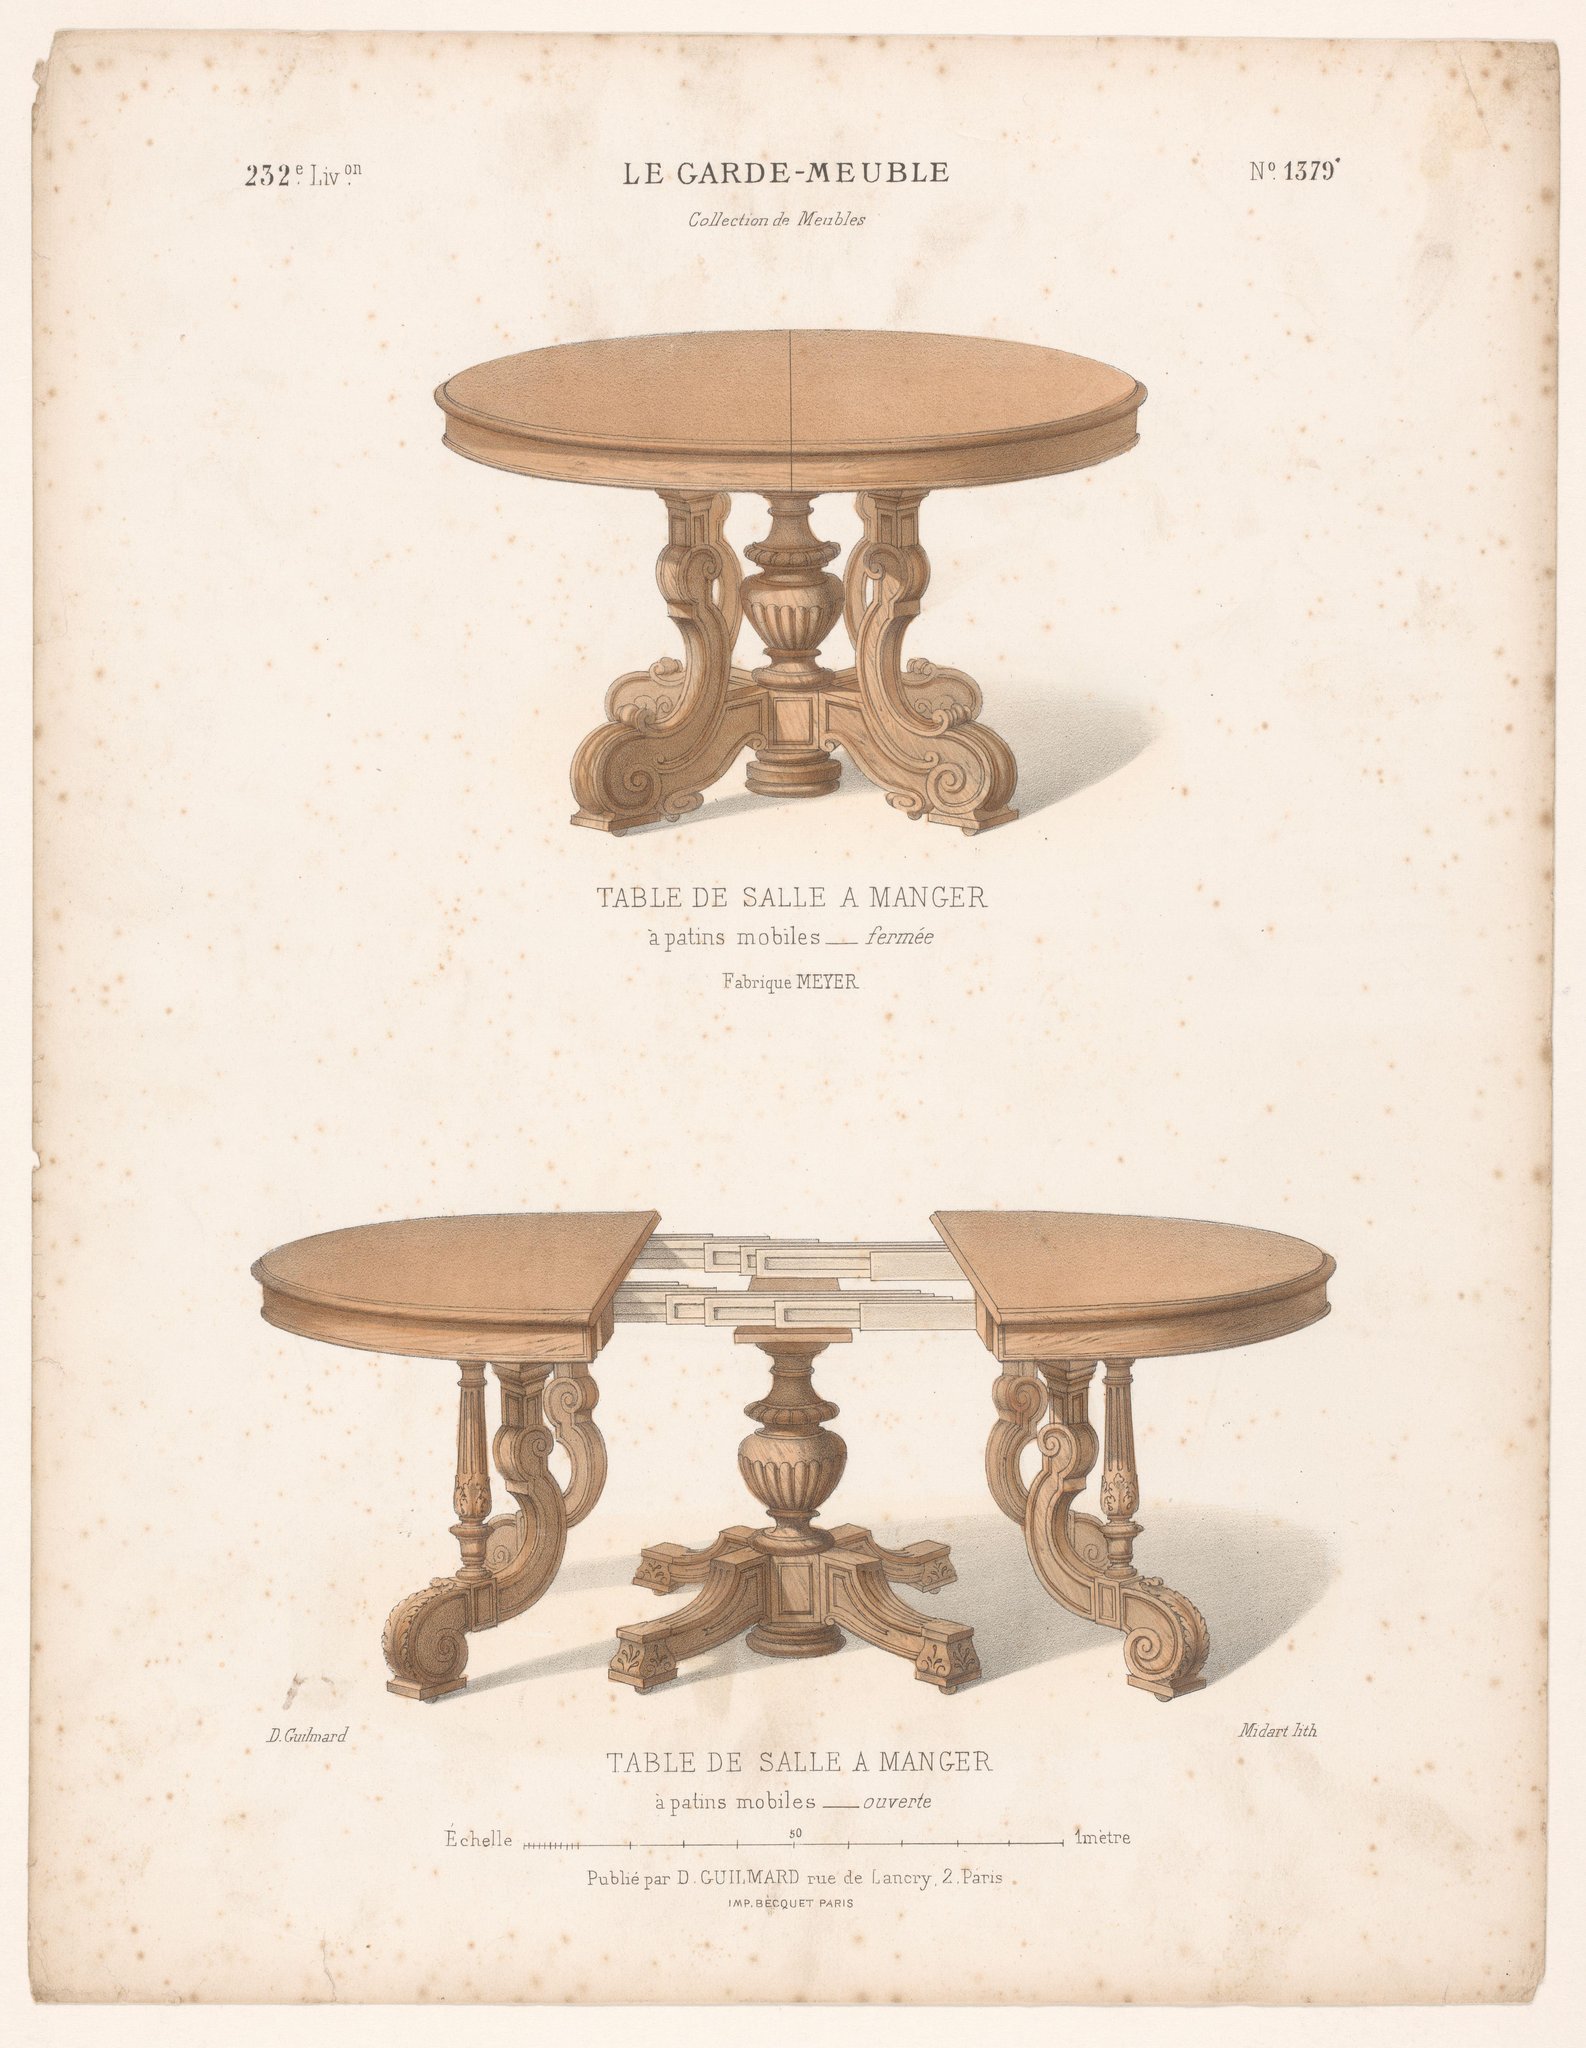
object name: print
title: Eettafel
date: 1839-1885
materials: paper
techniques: hand coloring, lithograph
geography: paris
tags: table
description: Ieder Livraison in de serie Le Garde-Meuble bevat negen platen: drie 'sièges' (zitmeubels), drie 'meubles' (diverse meubels zoals tafels en kasten) en drie 'tentures' (gordijnen en draperieën).